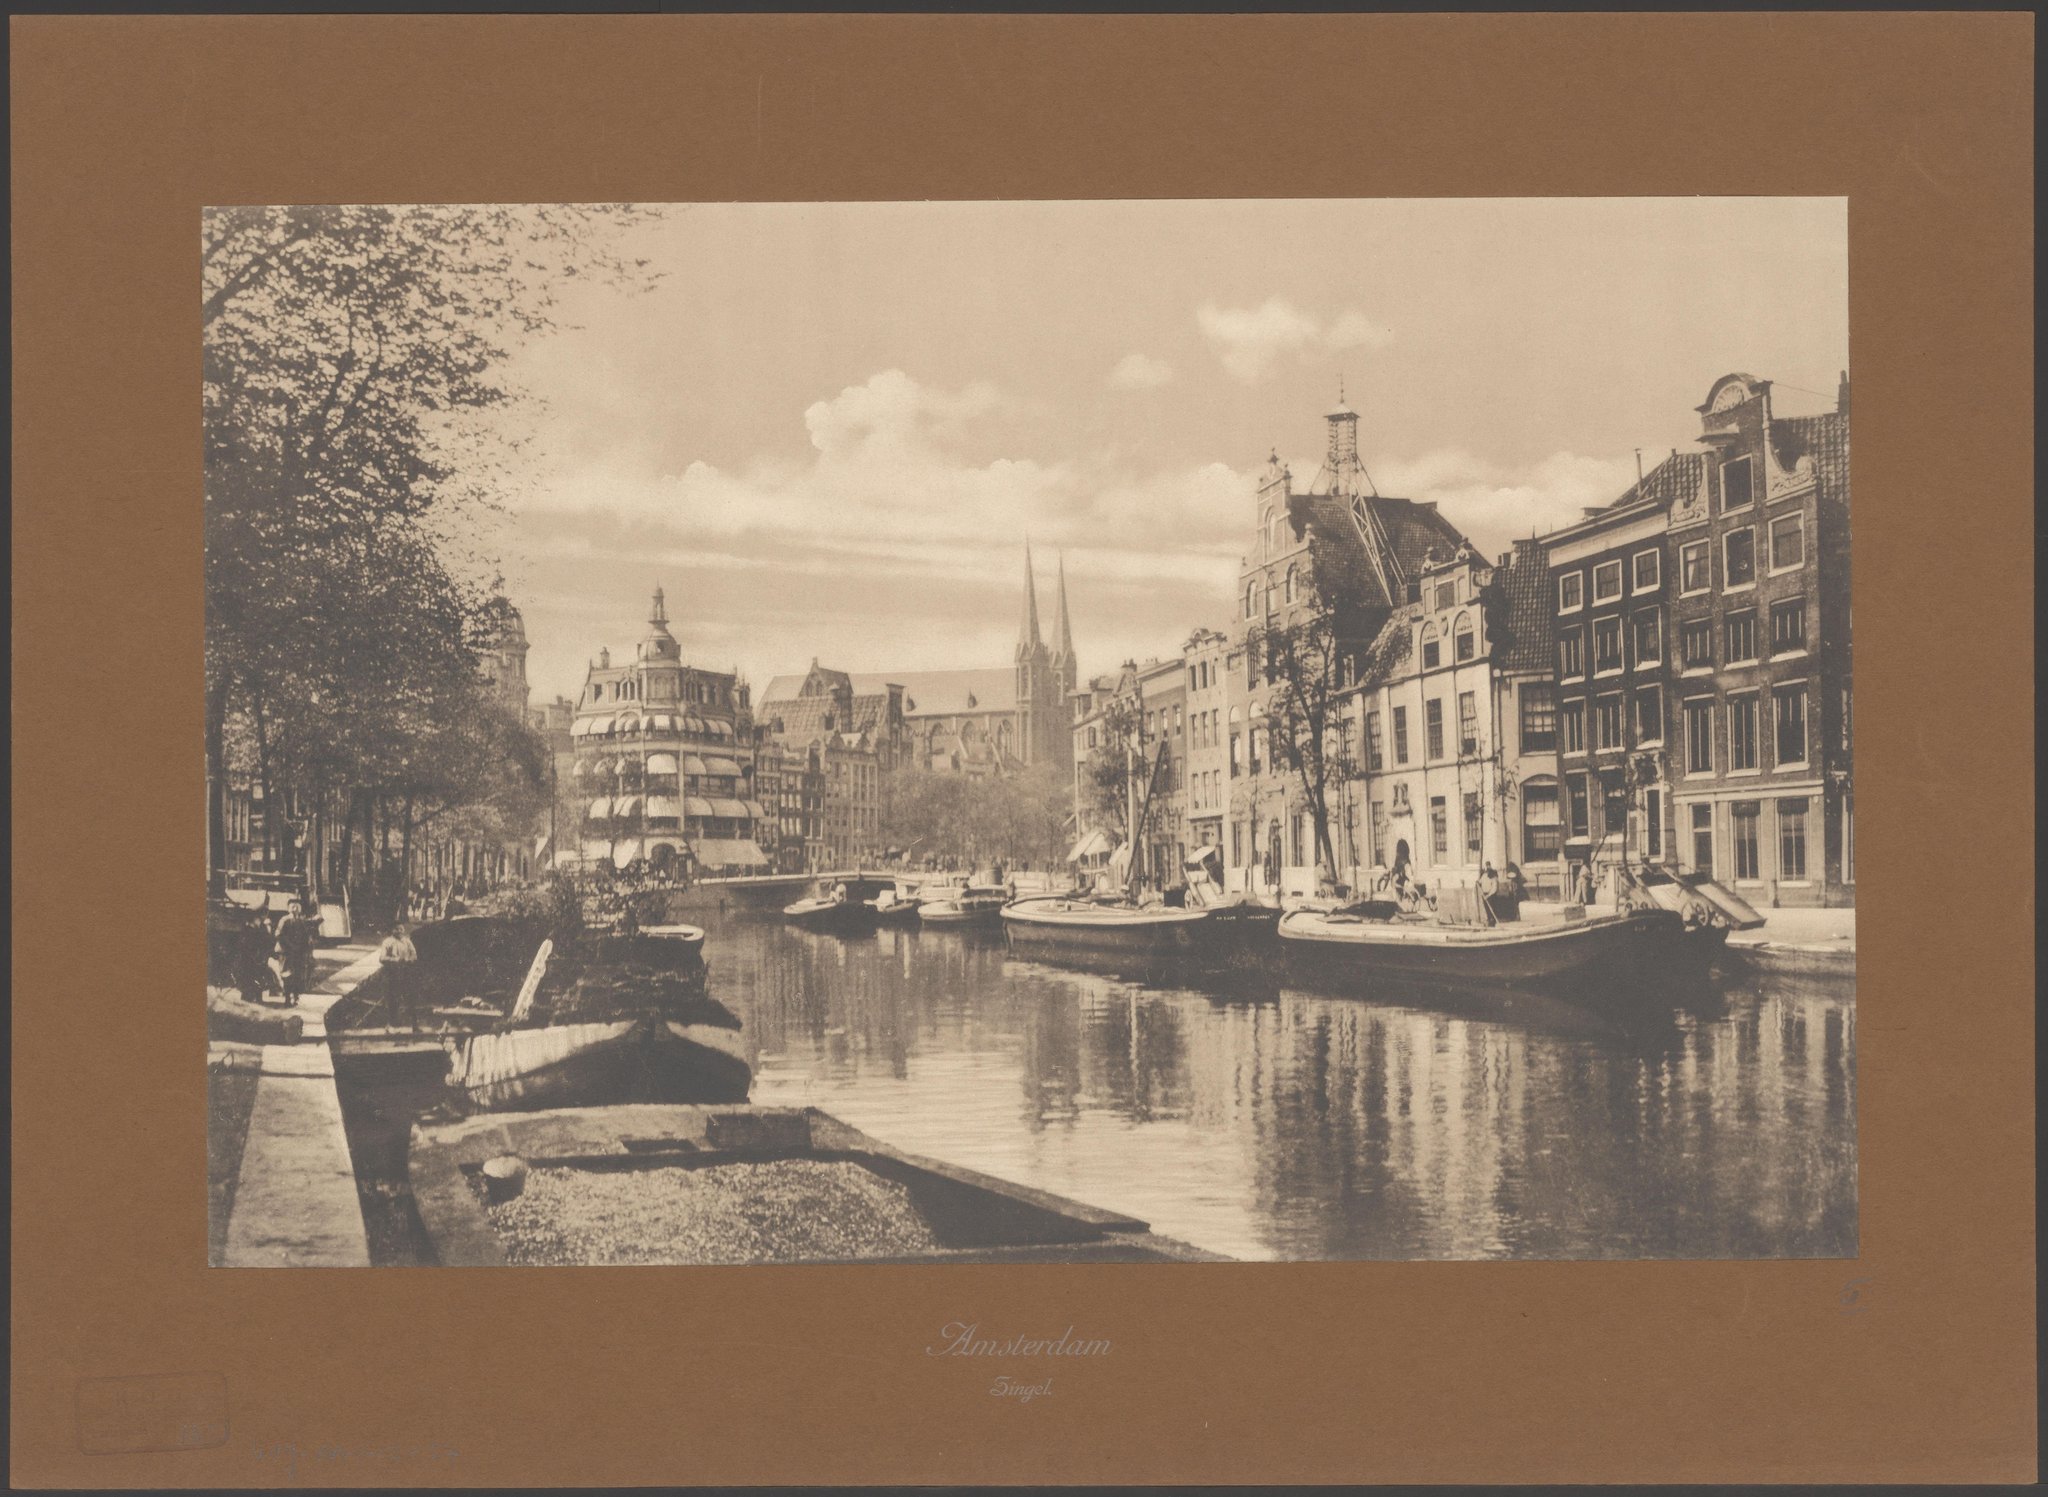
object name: photomechanical print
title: Gezicht op het Singel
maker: Anonymous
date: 1875-1930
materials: cardboard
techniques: photograph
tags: city-view in general; 'veduta', canal, church (exterior)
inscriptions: collector's mark: ‘13,57’ Lugt 1641b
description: Onderwerpsrubriek binnen de Atlas Amsterdam: Oude Schans, Schoutensteeg, Singel (Korte), Singel.